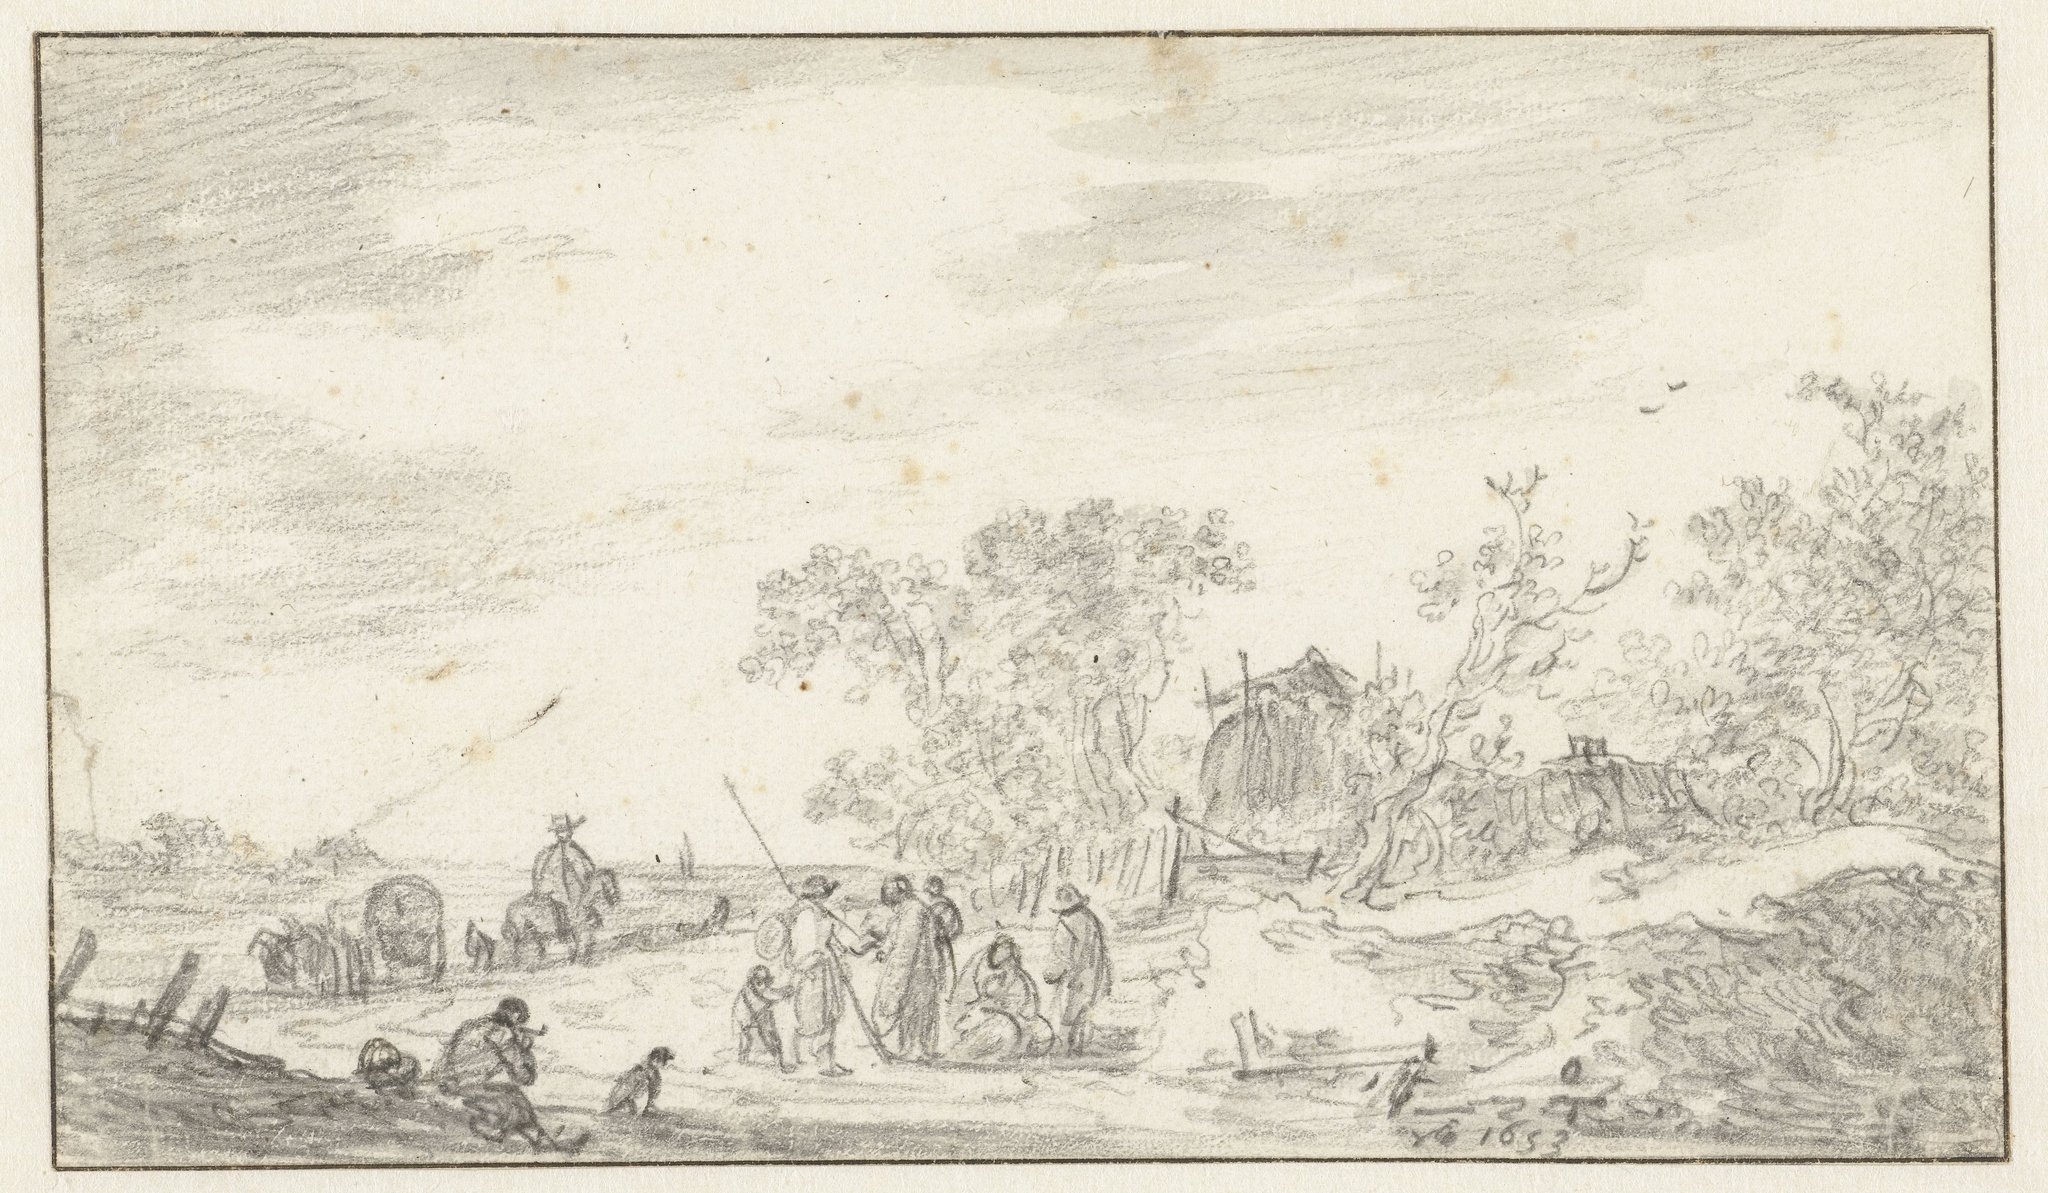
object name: drawing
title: Groep figuren langs een weg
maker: jan van goyen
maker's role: draughtsman, painter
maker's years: 1596-1656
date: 1653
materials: chalk, paper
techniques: brush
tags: animal traction, animal-drawn vehicle (carriage etc.), (traveller) resting in the open air, farm or solitary house in landscape